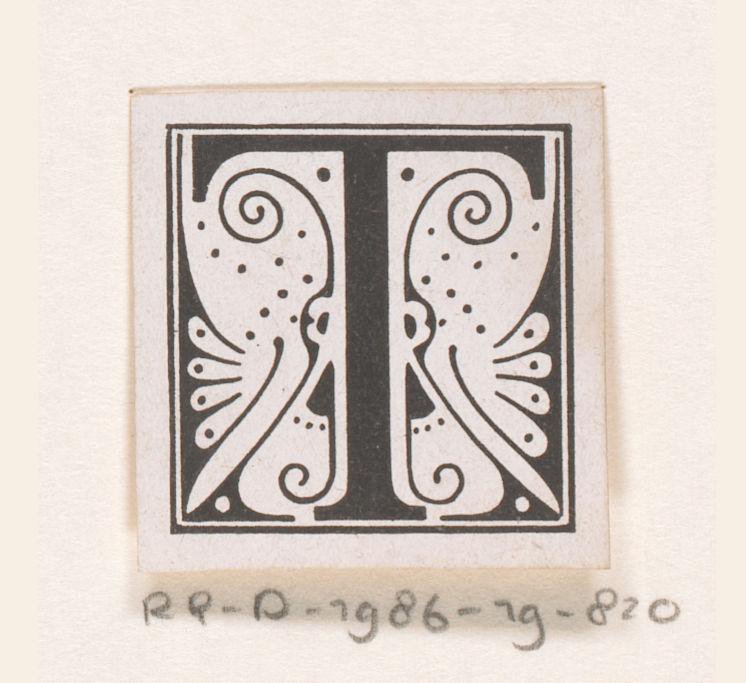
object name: photomechanical print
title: Initiaal T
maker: reinier willem petrus de vries (1874-1953)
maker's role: draughtsman, print maker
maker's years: 1874-1953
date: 1904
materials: paper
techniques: printing block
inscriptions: collector's mark: ‘R:MVS.’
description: Het initiaal is gebruikt voor: Veth, Jan. Jozef Israëls en zijn kunst. Arnhem en Nijmegen: Gebroeders E&M Cohen, 1904.